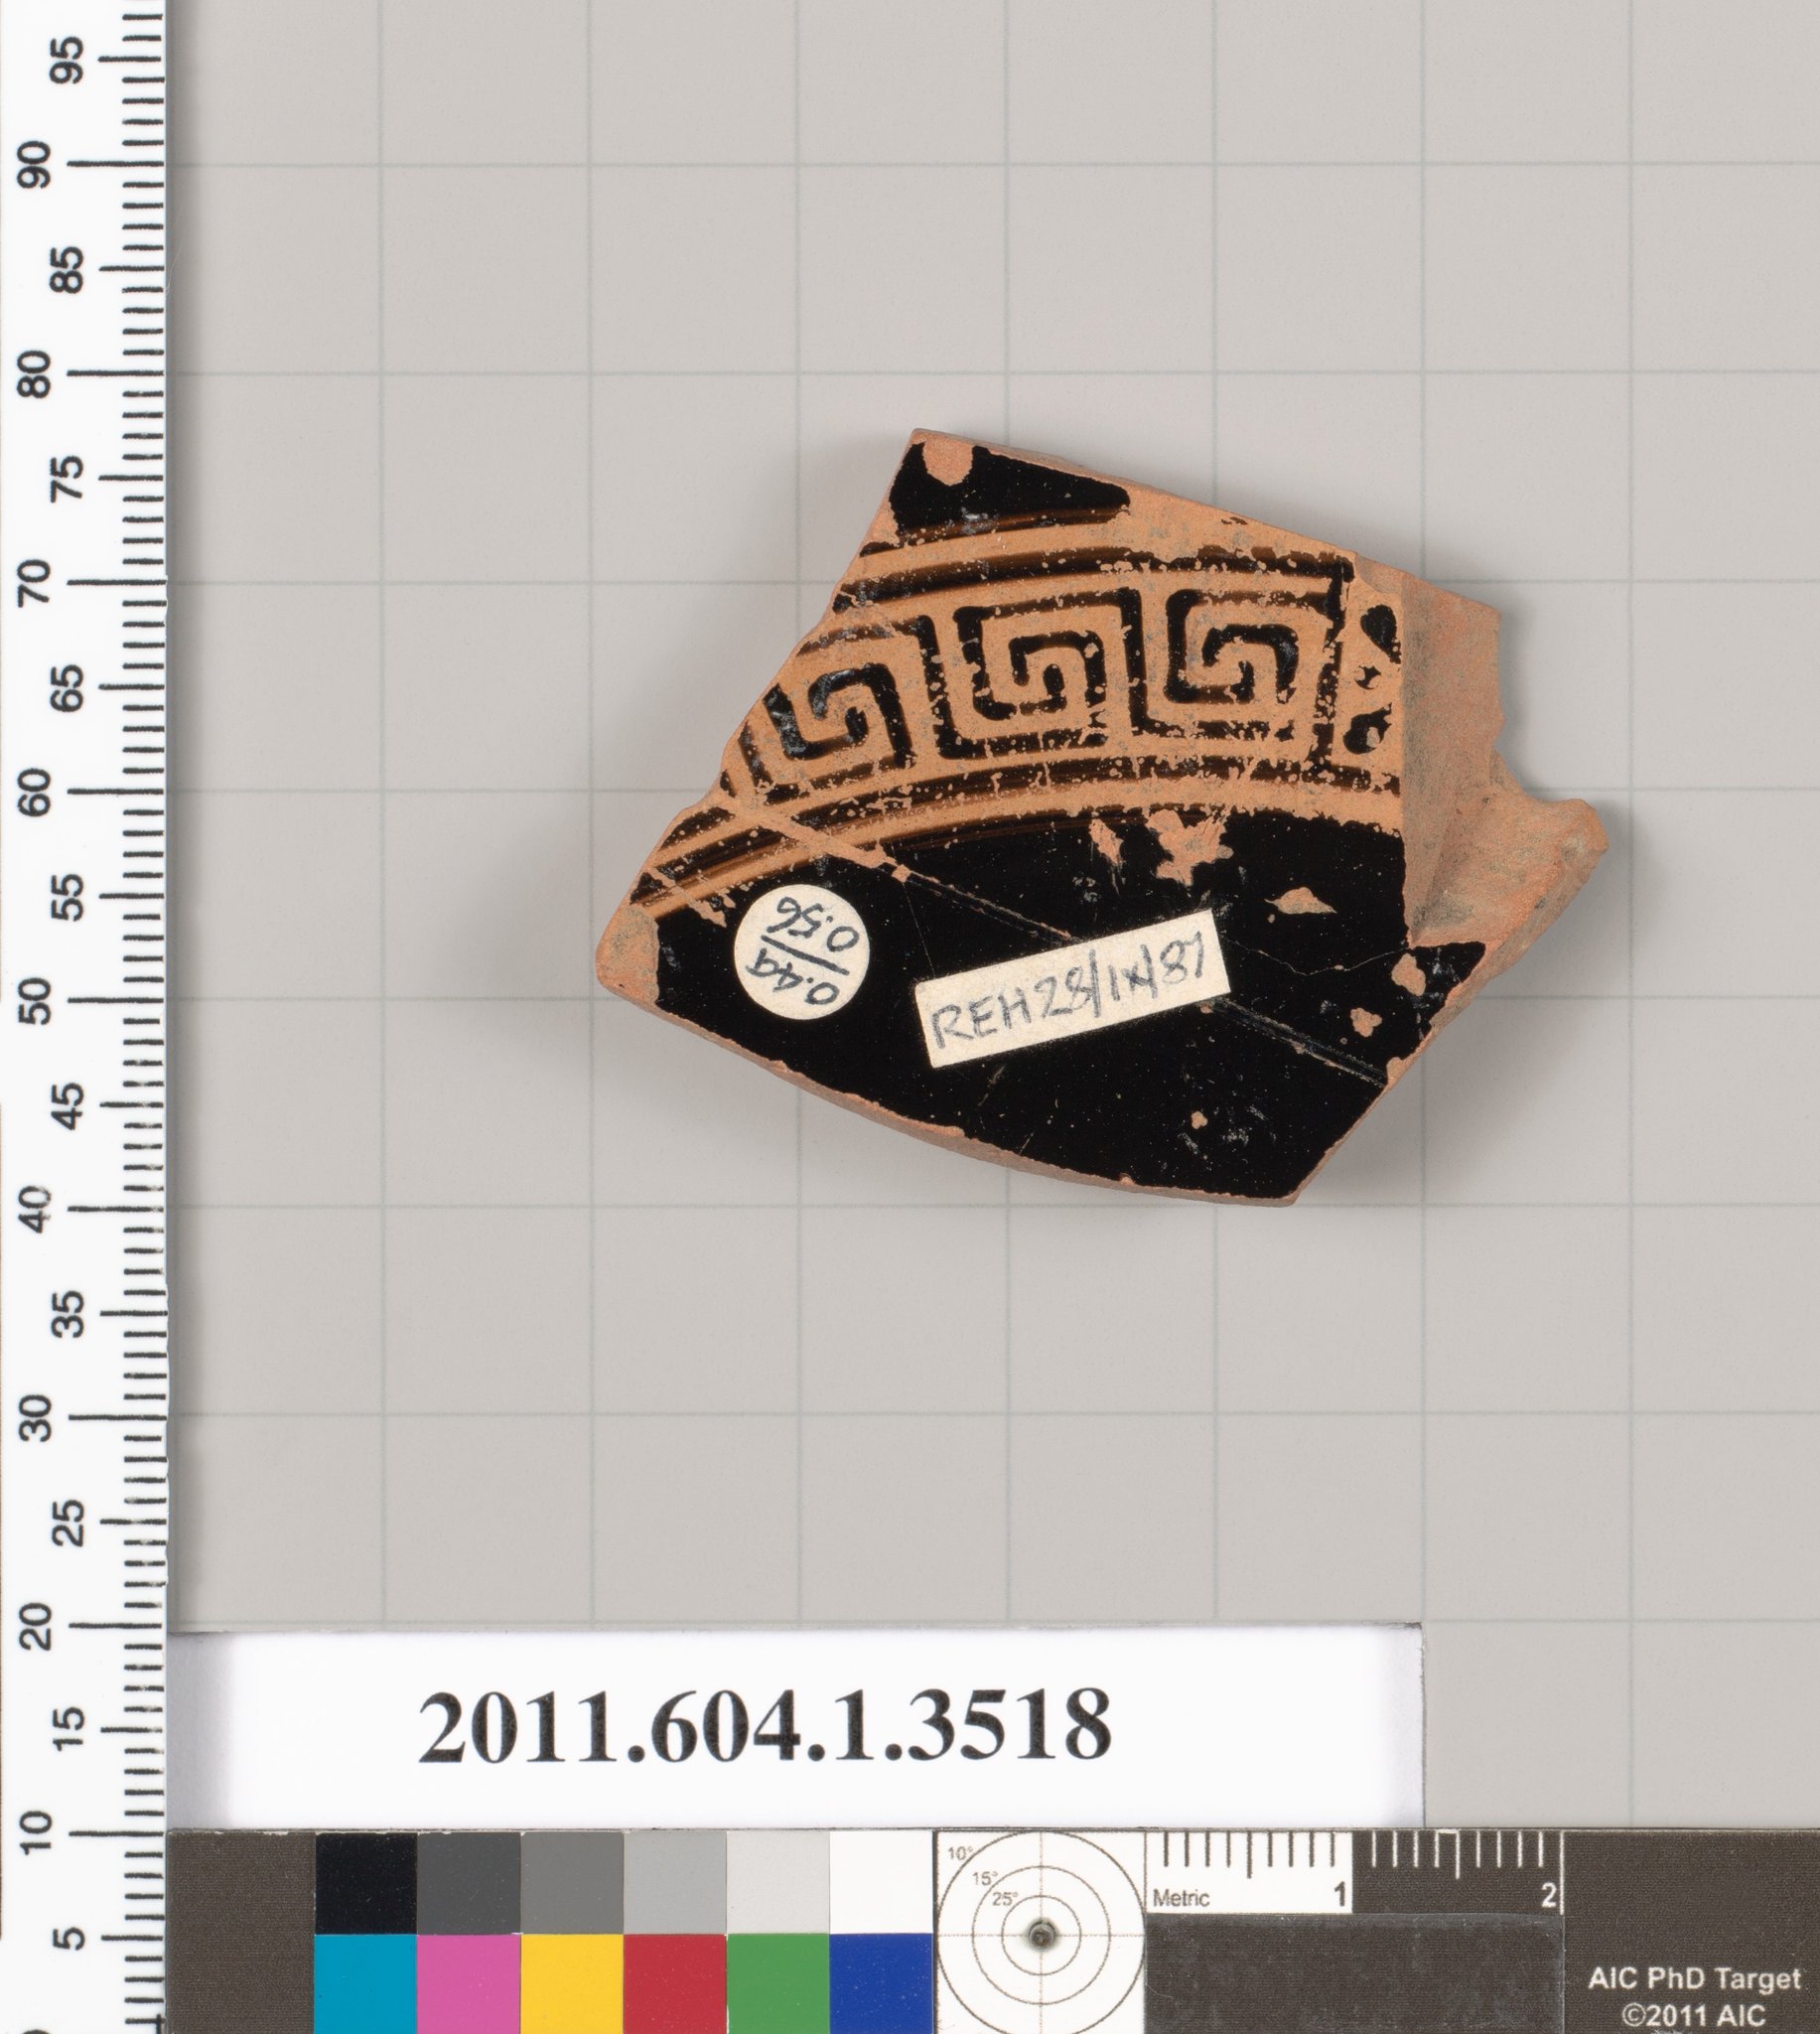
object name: kylix fragment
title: Terracotta fragment of a kylix (drinking cup)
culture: greek, attic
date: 475-451 BCE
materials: terracotta